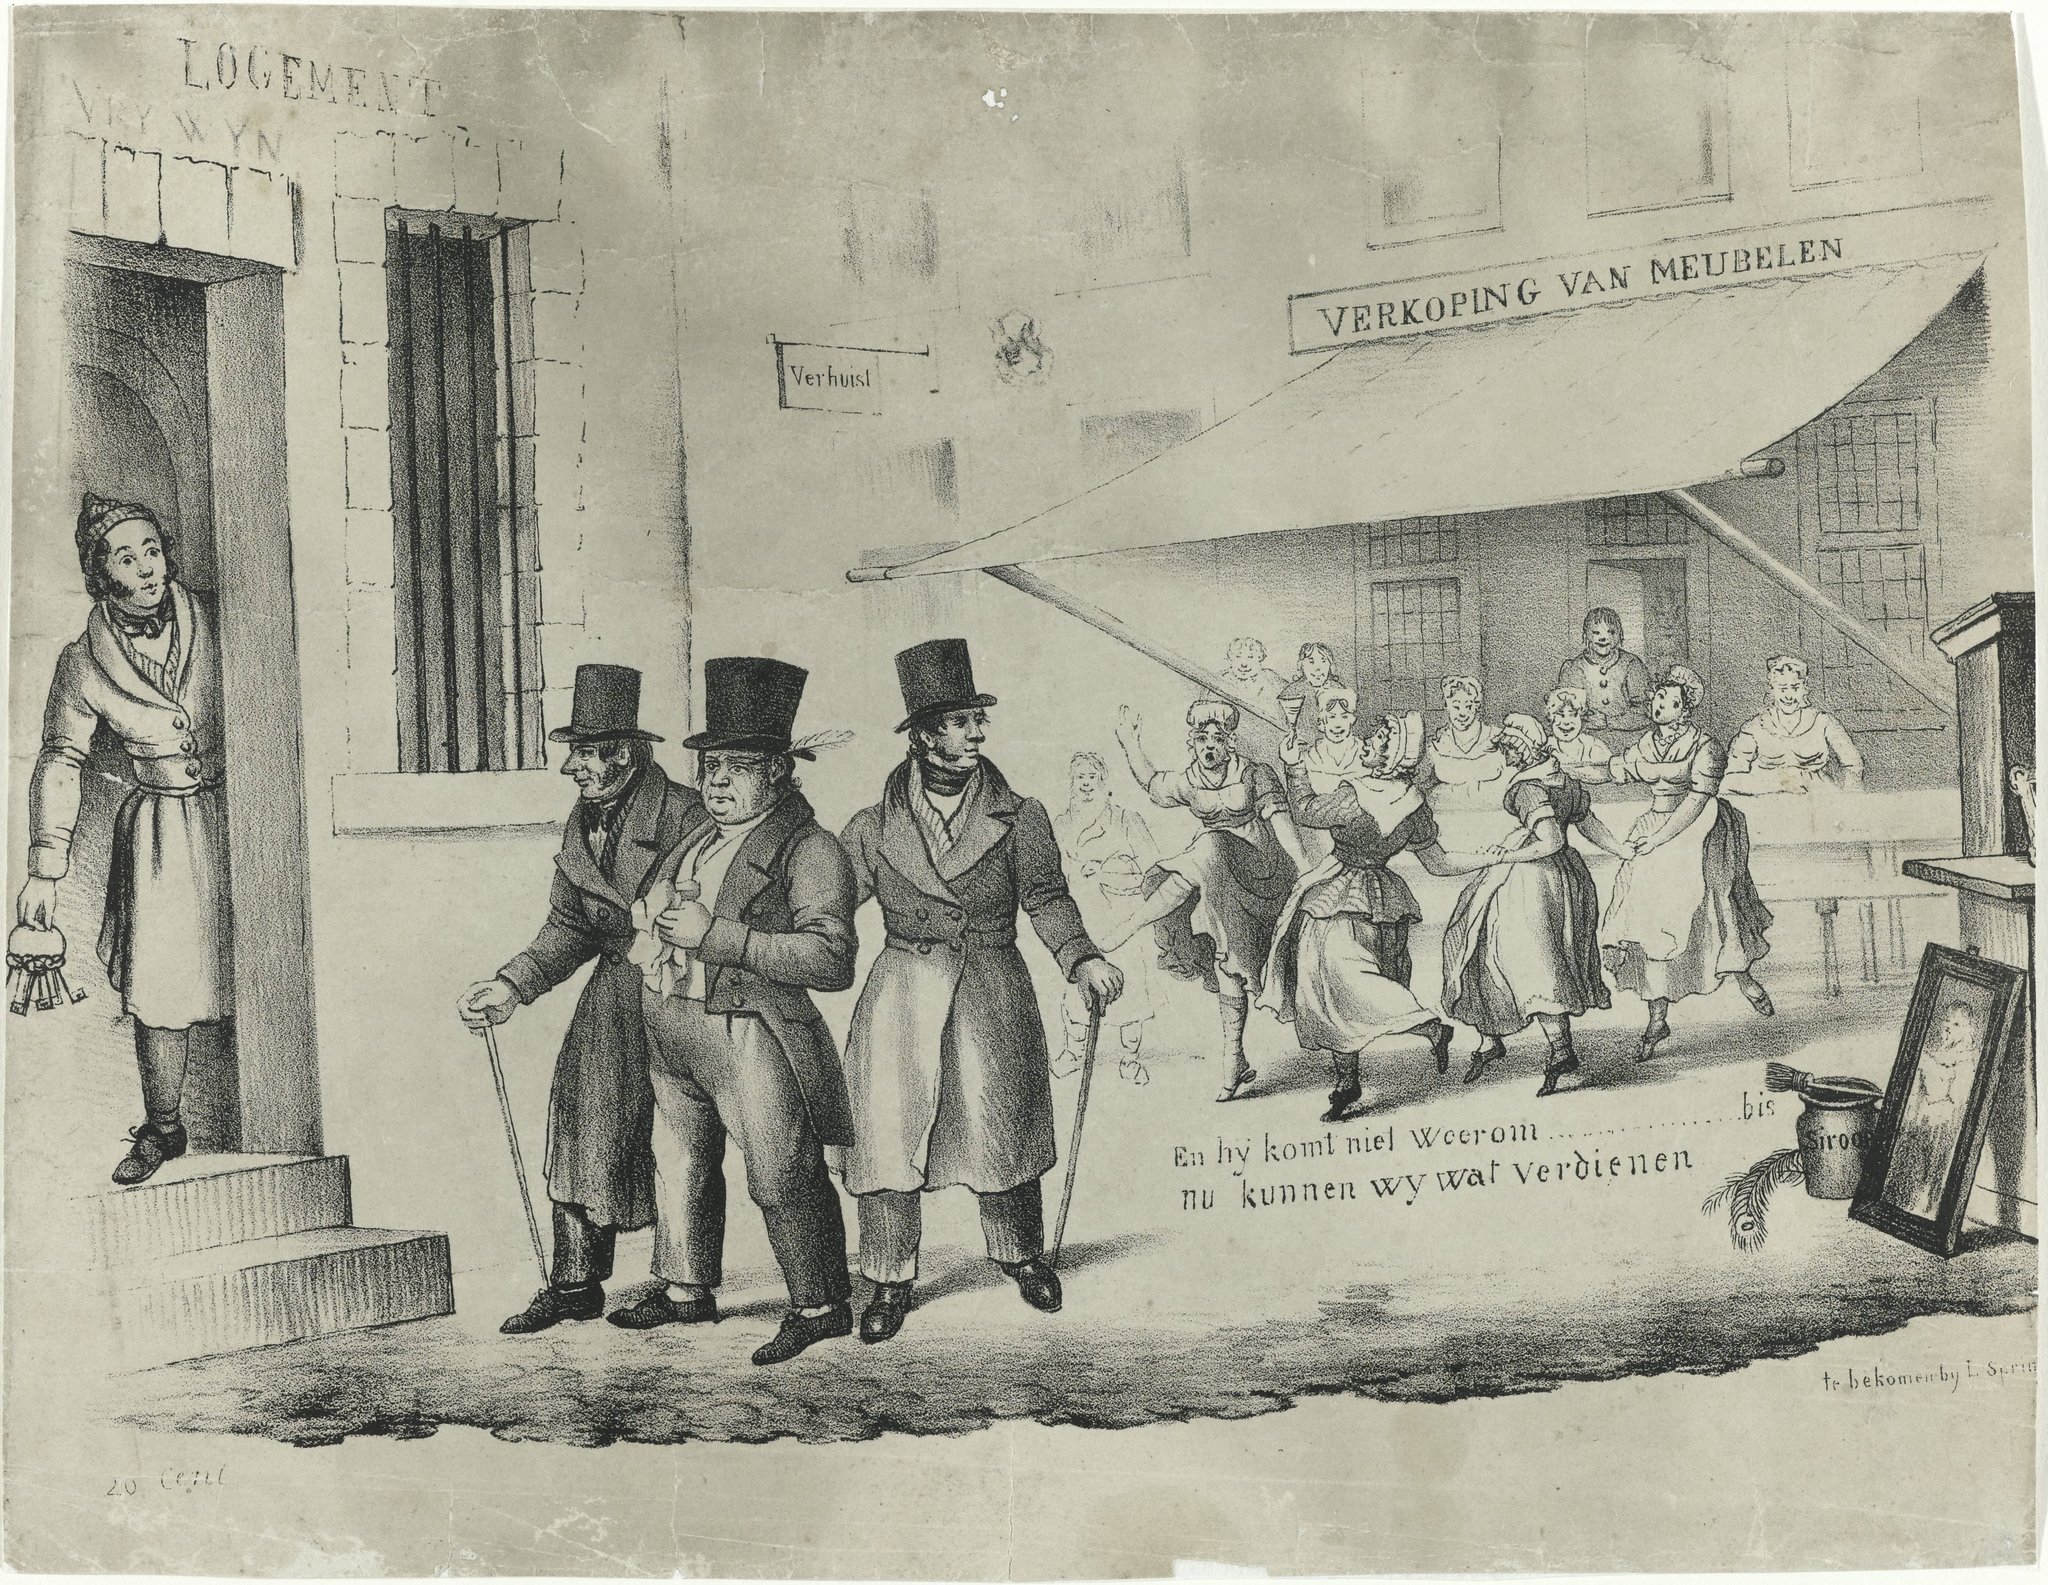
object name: cartoon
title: Spotprent op C. Seyn, 1838-1839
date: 1838-1839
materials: paper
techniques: lithograph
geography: leiden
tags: prison, jail, transport (of arrested person), leiden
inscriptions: collector's mark: Lugt 2228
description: Spotprent op de Leidse klerk C. Seyn die door twee agenten naar de gevangenis wordt geleid. Op de achtergrond een venduhuis voor meubelen waar een groep vrouwen zingen en dansen van blijdschap over de arrestatie. Ten behoeve van zijn liefhebberij (schilderijen) stal Seyn uit de stadskas. Rechts enkele schilderijen geleund tegen een kast, een pot siroop en een pauwenveer. De diefstal werd ontdekt op 10 oktober 1838, het vonnis uitgesproken op 27 september 1839.